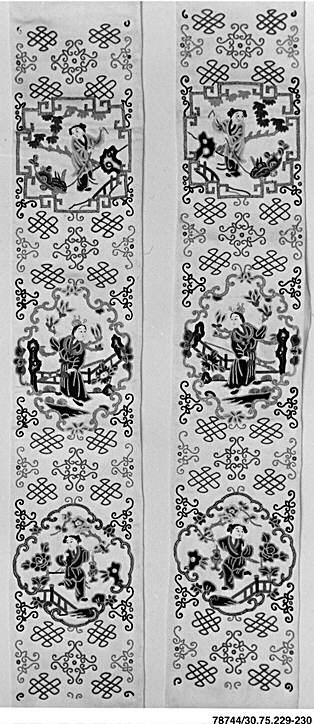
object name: sleeve band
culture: chinese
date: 1801-1900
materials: metal thread, silk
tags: human figures